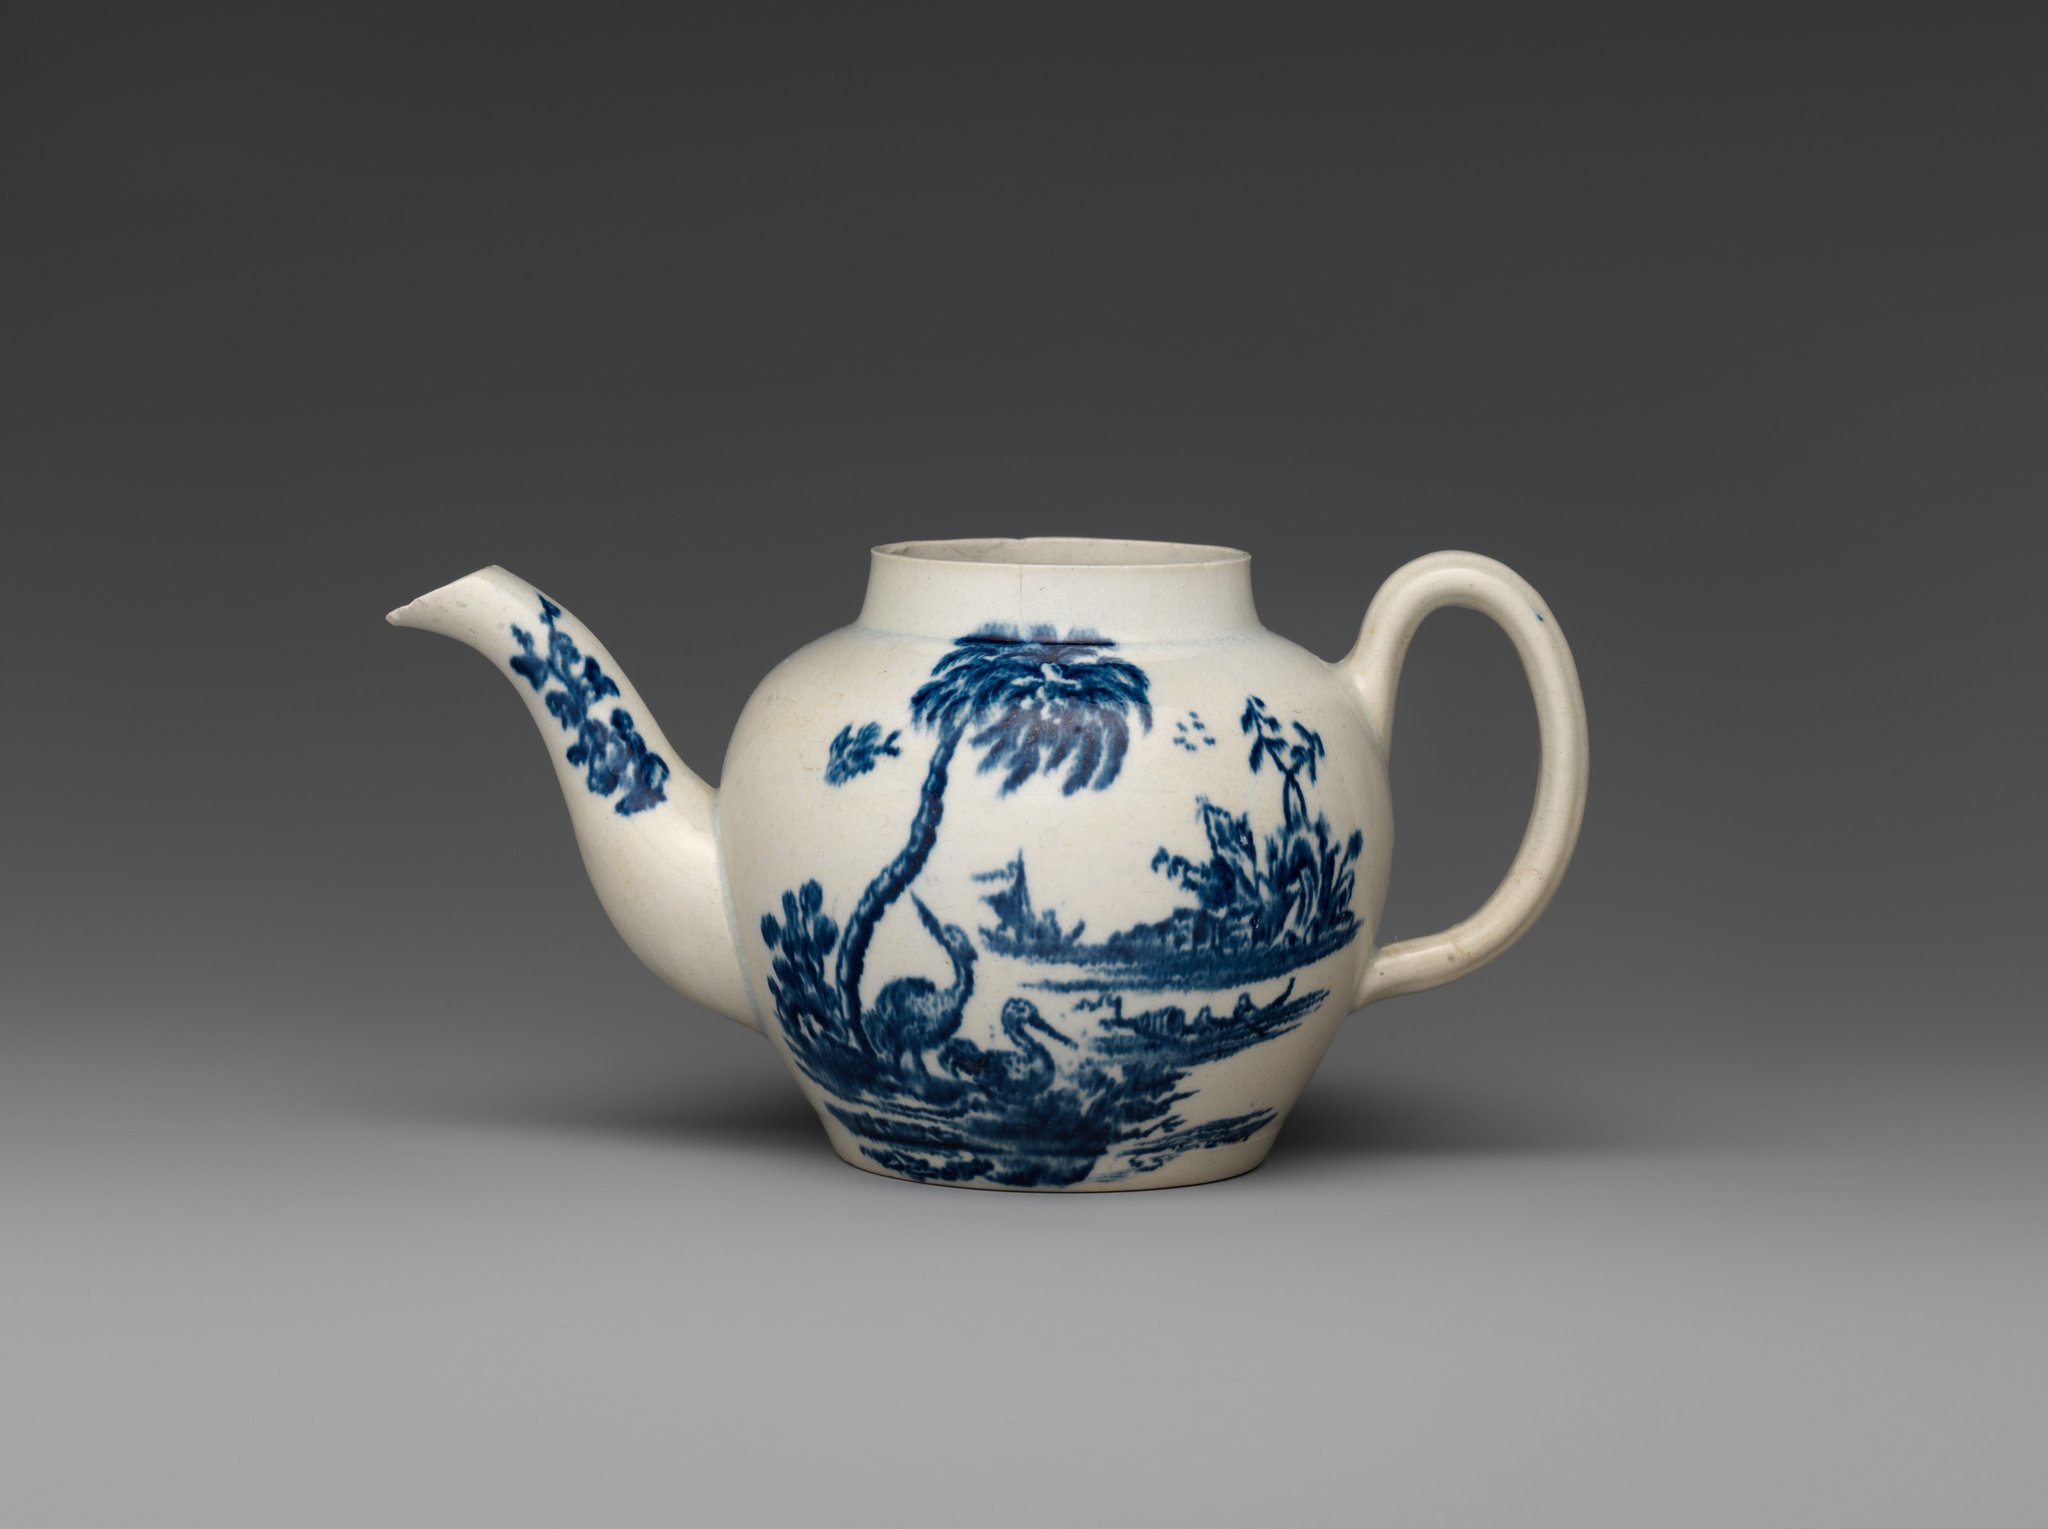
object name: teapot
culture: american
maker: john bartlam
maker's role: manufacturer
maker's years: 1735-1781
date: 1765-1769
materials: soft paste porcelain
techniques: underglaze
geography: united states